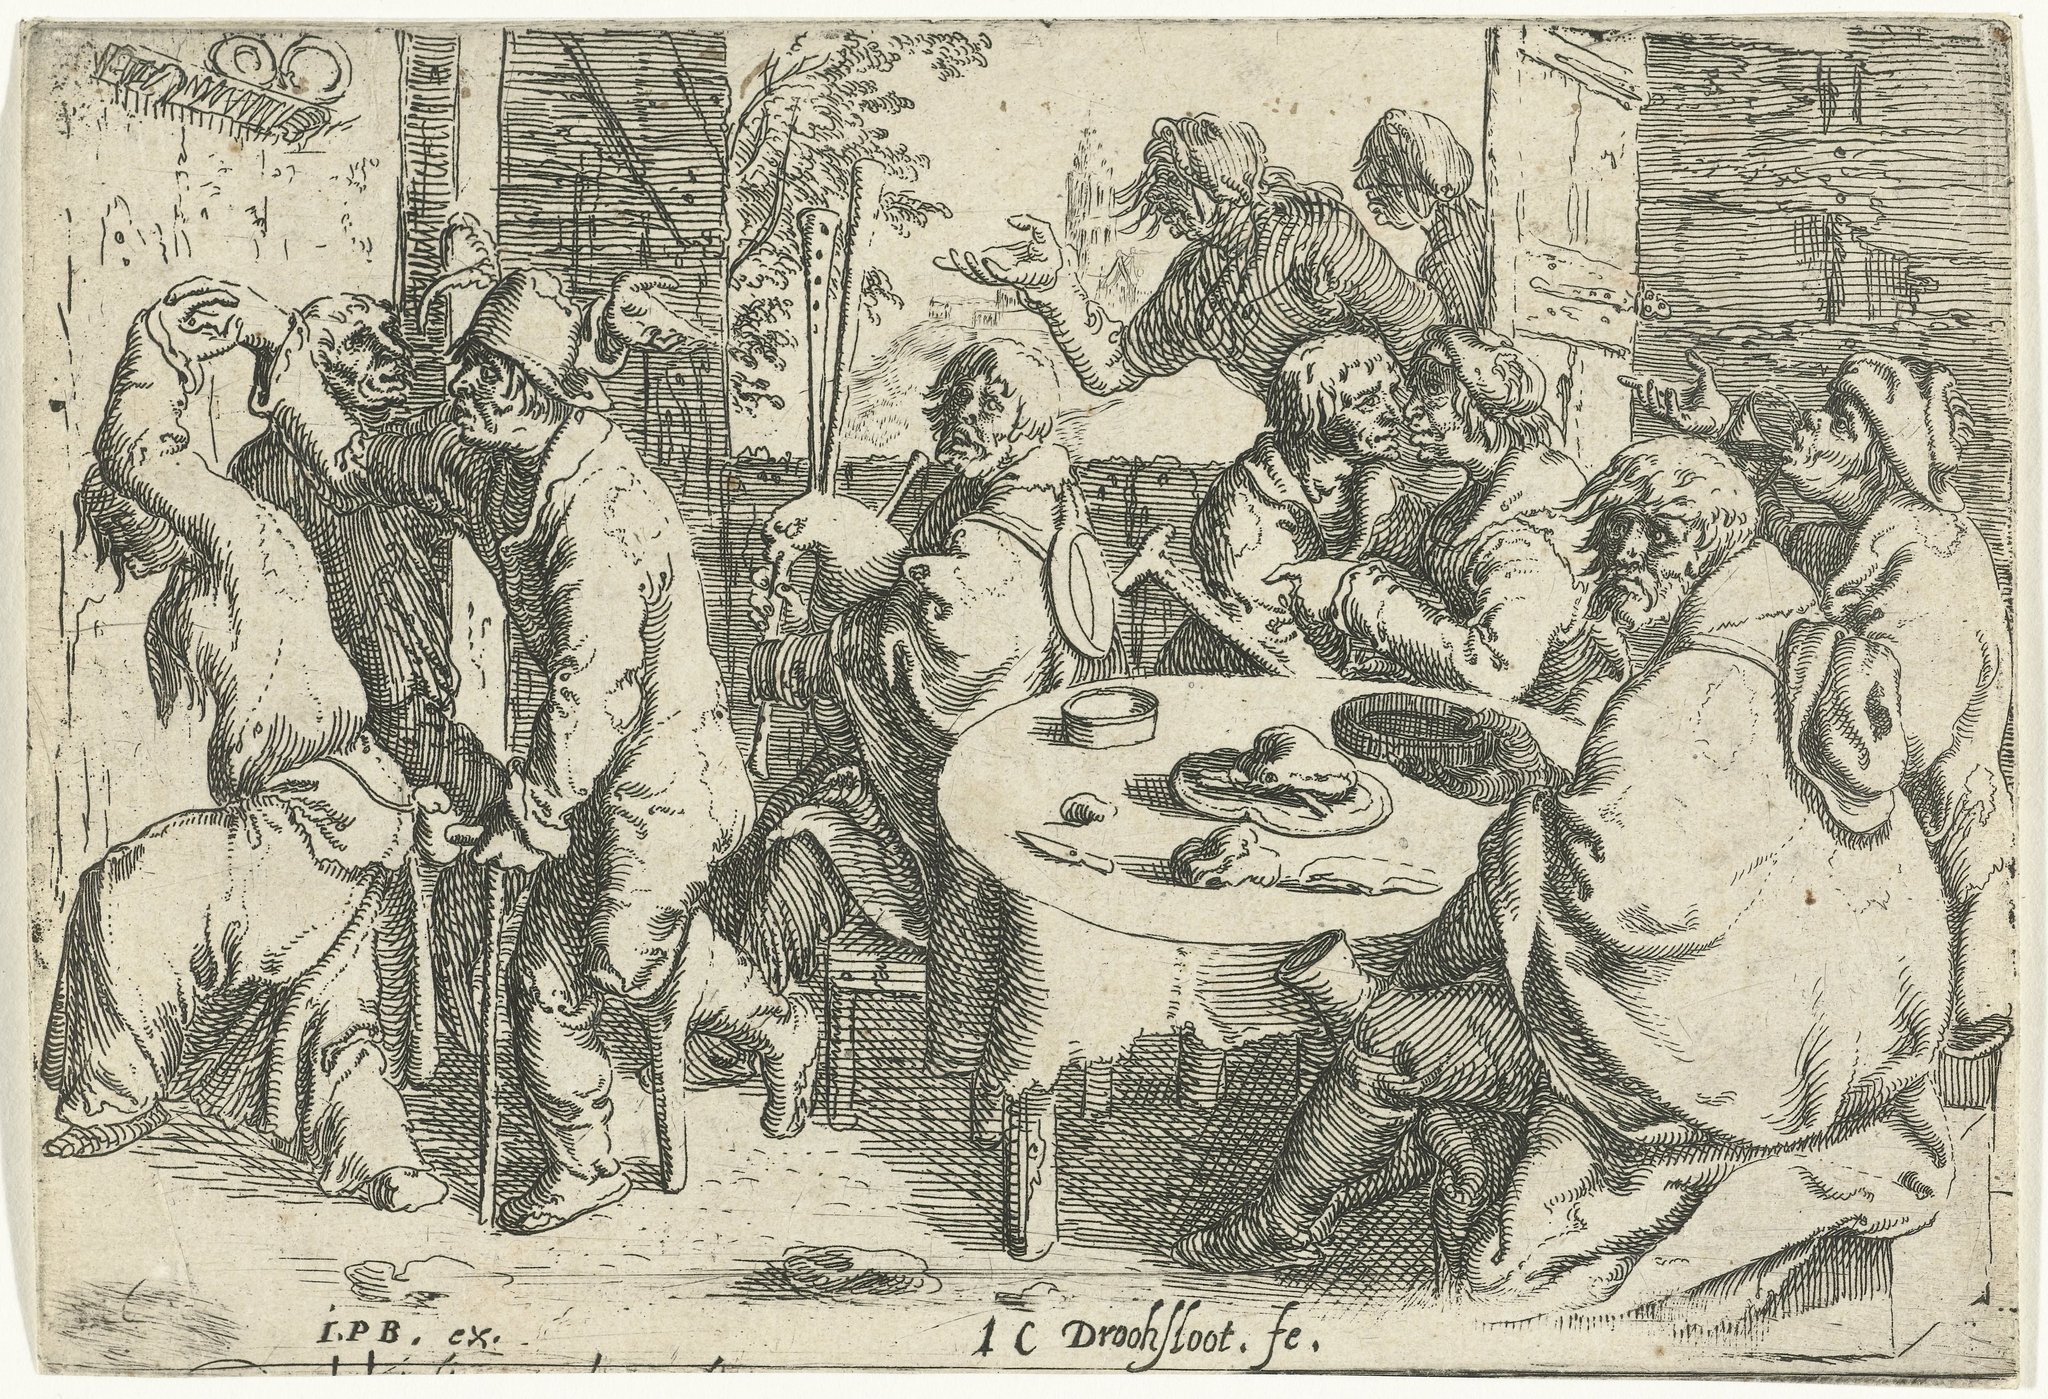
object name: print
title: Drie bedelaars en een vrouw aan tafel in een herberg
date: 1618-1648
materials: paper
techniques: etching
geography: utrecht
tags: wooden leg, bagpipe, musette, beggar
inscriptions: collector's mark: Lugt 240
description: Drie bedelaars zitten in een herberg aan tafel. De ene wordt vergezeld door een vrouw. Op een stoel bij het raam zit een doedelzakspeler. Links danst een kreupel met een andere bedelaar.